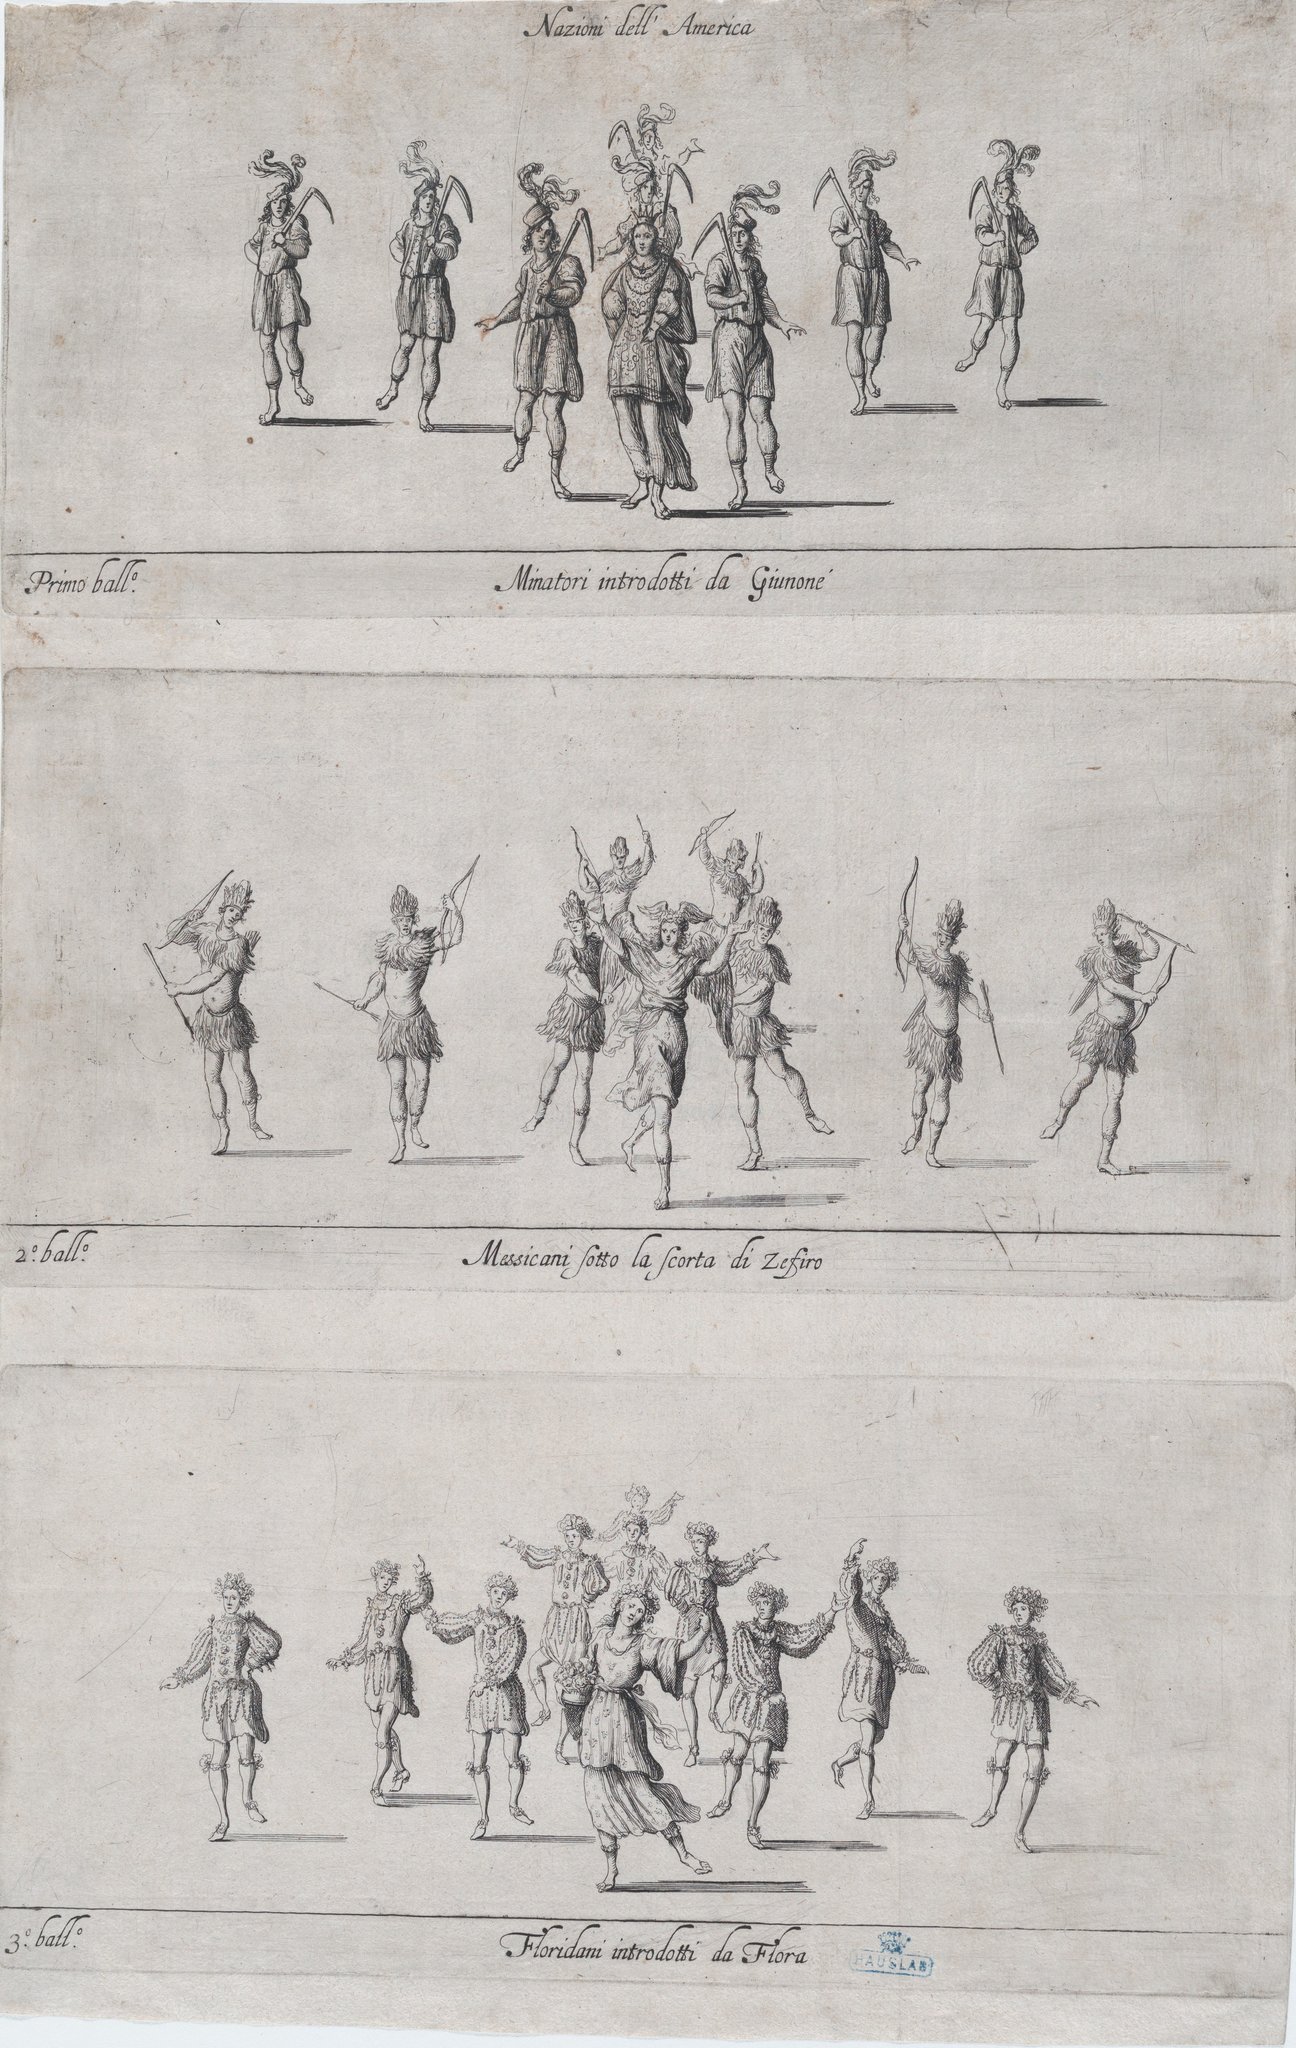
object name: print, fete, ornament architecture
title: Nations of America ballets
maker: anonymous, italian, 17th century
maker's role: artist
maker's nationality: italian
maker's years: 1600-1700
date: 1601-1700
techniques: etching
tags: dancing,juno